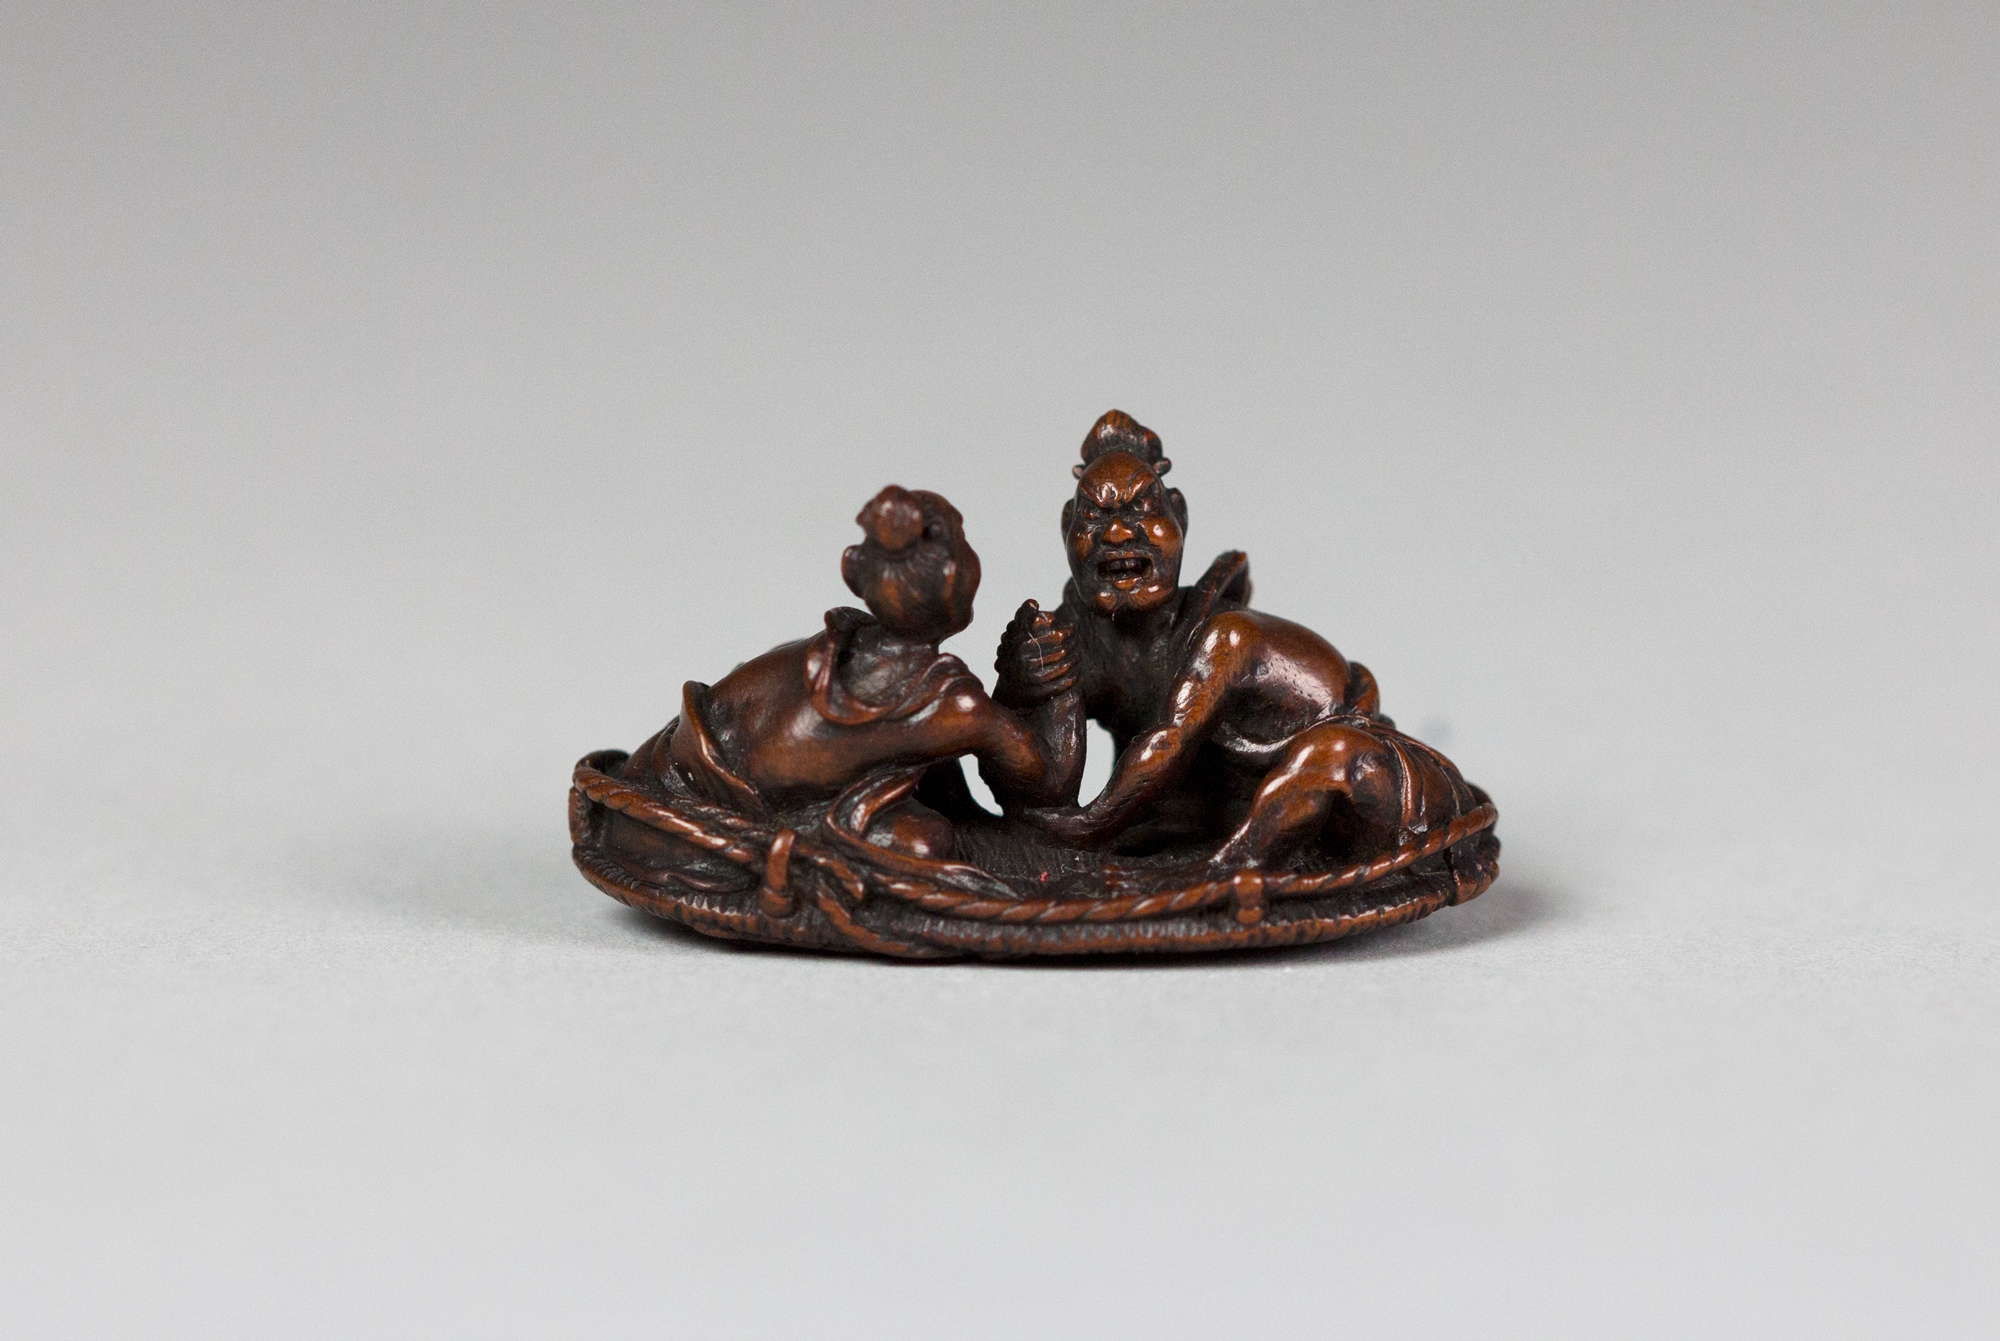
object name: netsuke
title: Netsuke of Two Figures Arm-Wrestling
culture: japanese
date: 1801-1900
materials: wood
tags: men